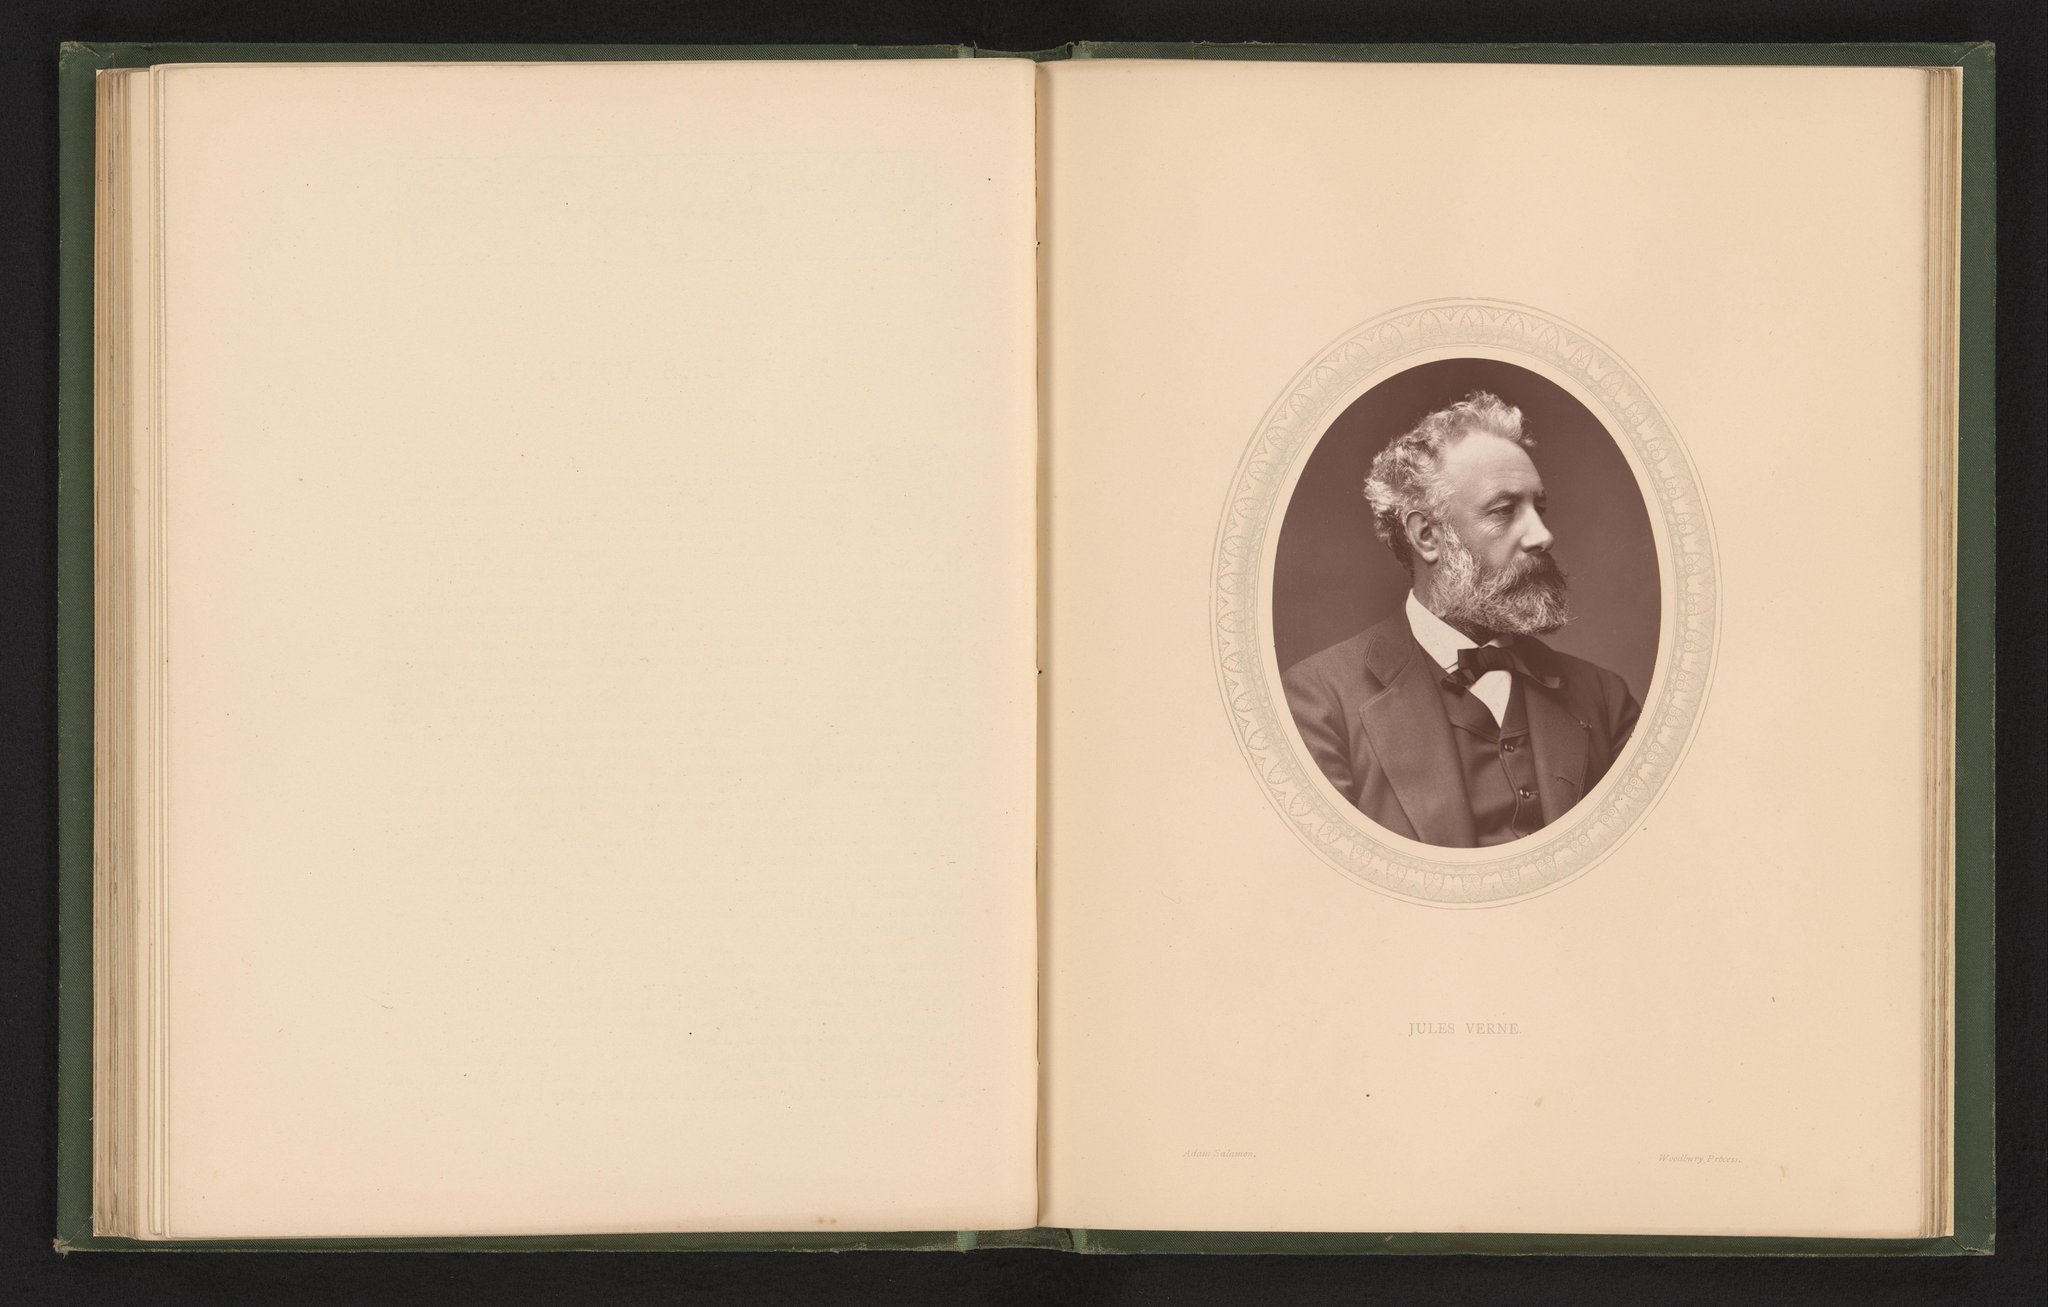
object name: photomechanical print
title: Jules Verne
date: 1872-1877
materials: paper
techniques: woodburytype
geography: france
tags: portrait of a writer, historical persons (portraits and scenes from the life) (+ (full) bust portrait)